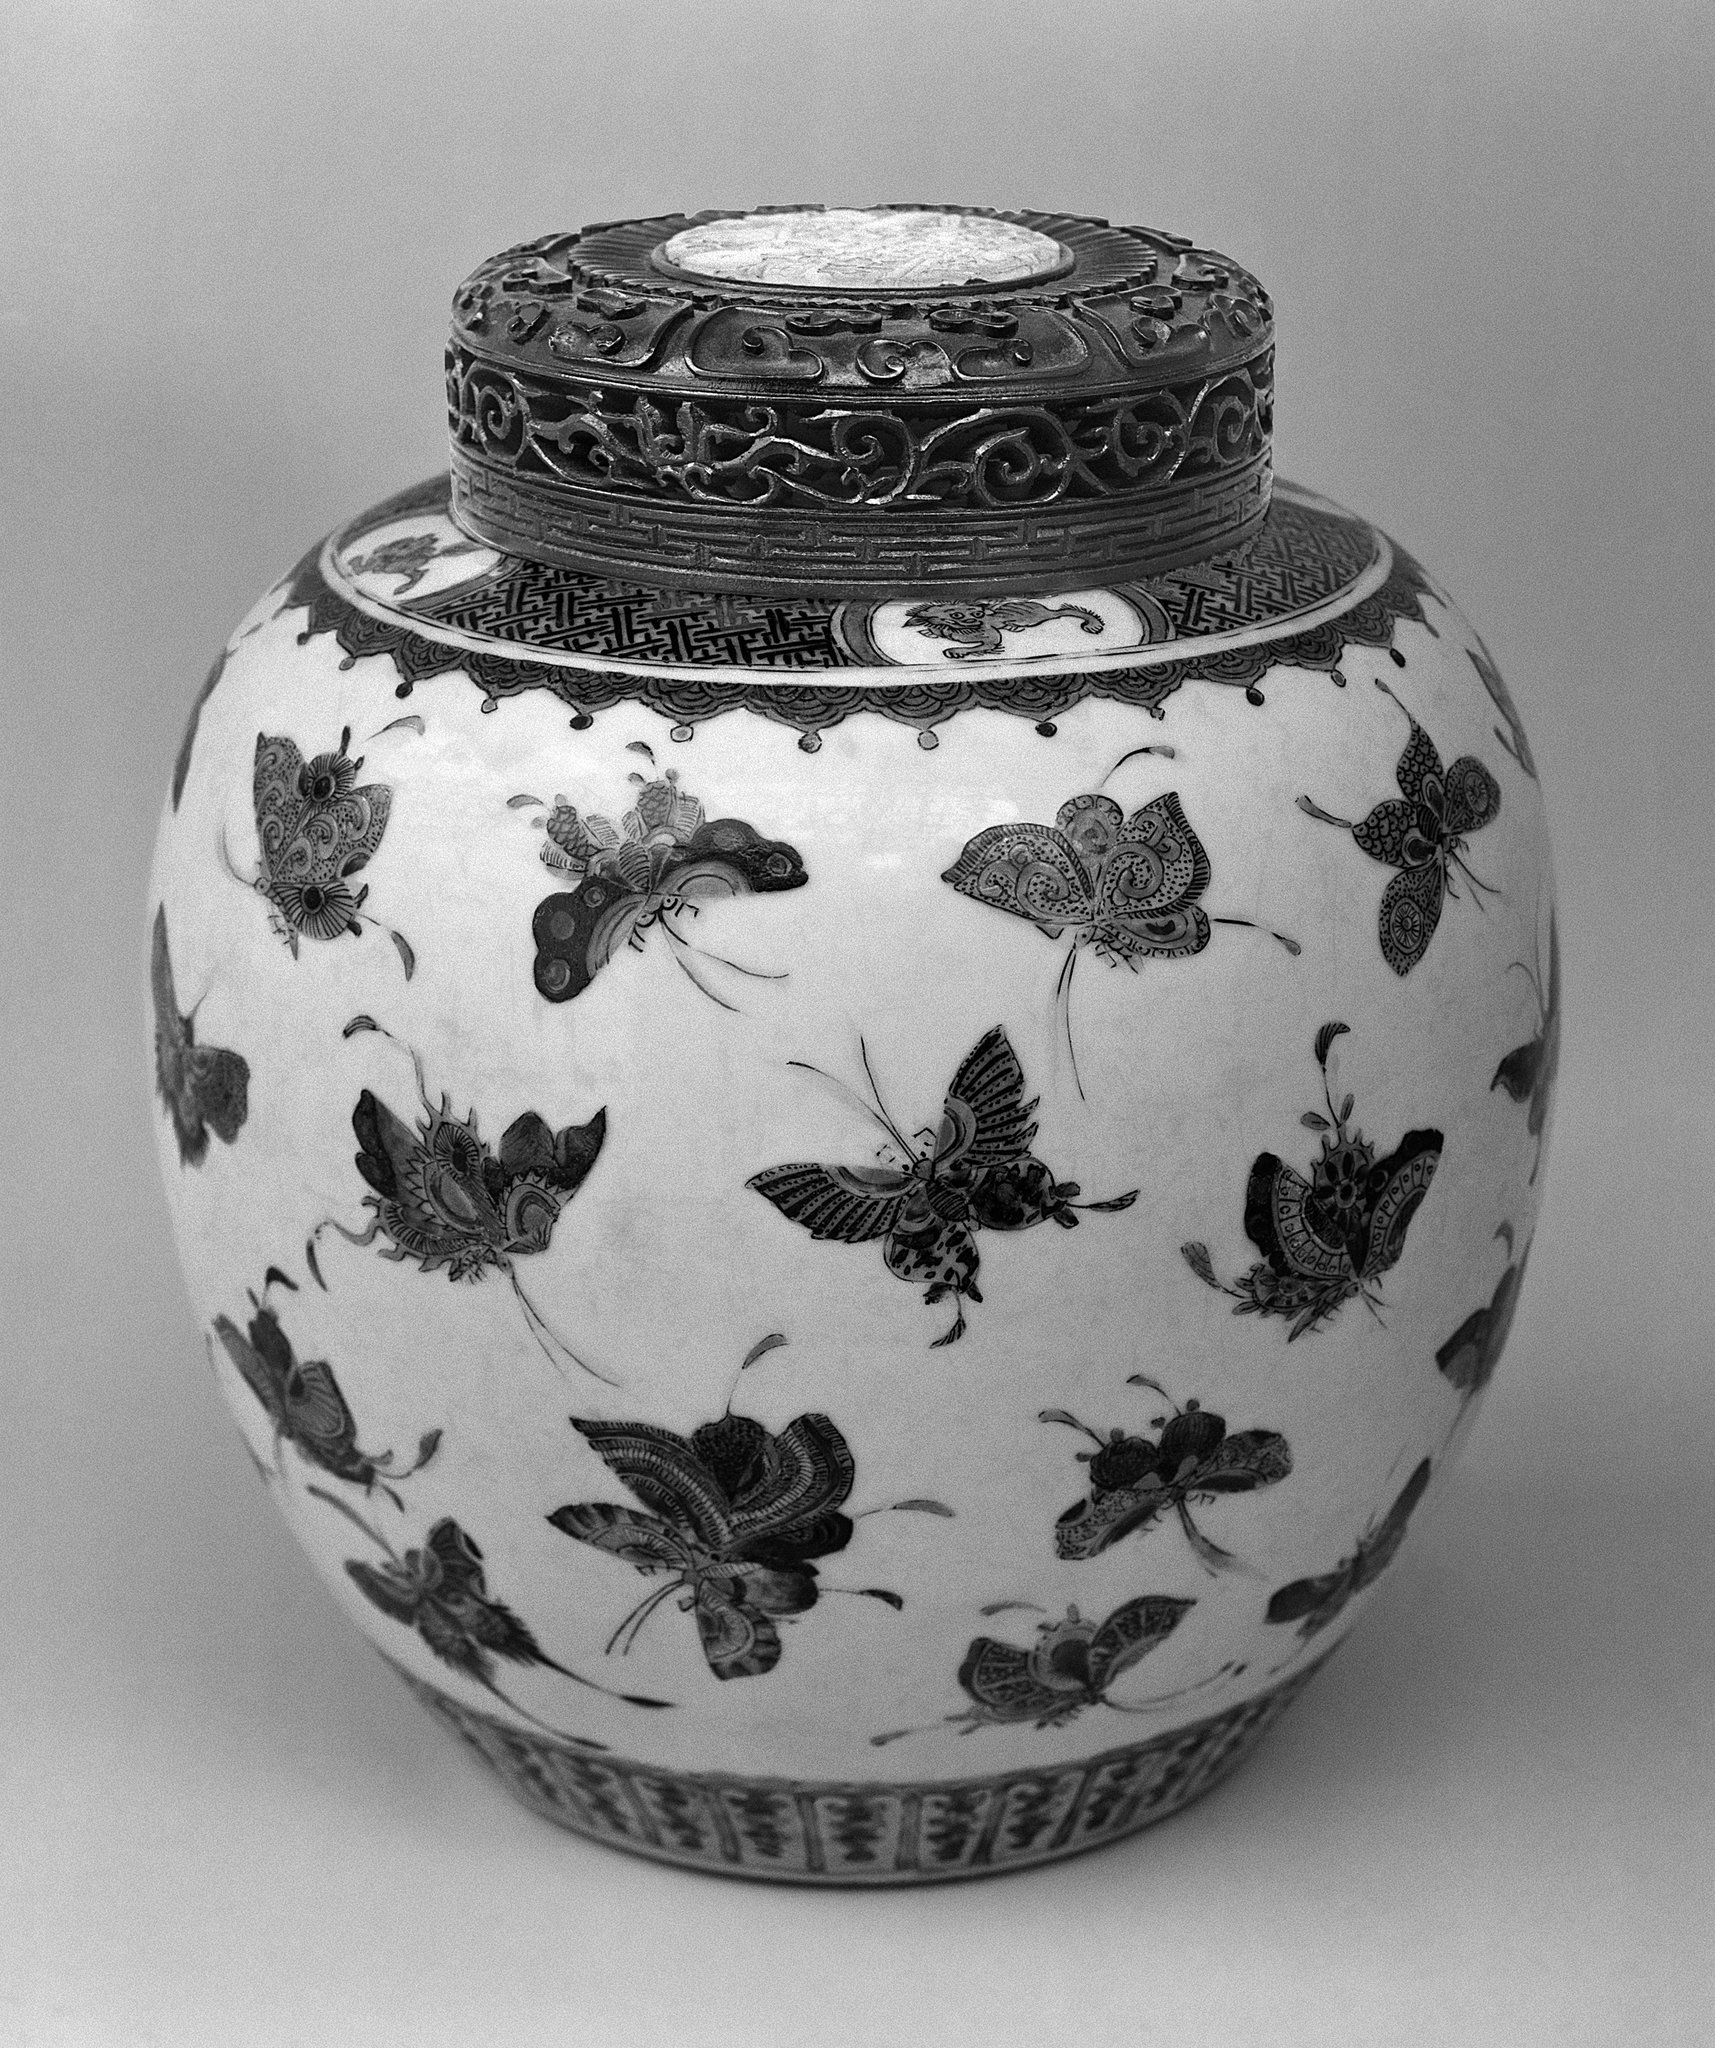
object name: jar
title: Jar with butterflies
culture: chinese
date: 1667-1733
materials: enamel, jade, porcelain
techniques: inlay, overglaze, painting, polychrome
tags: butterflies